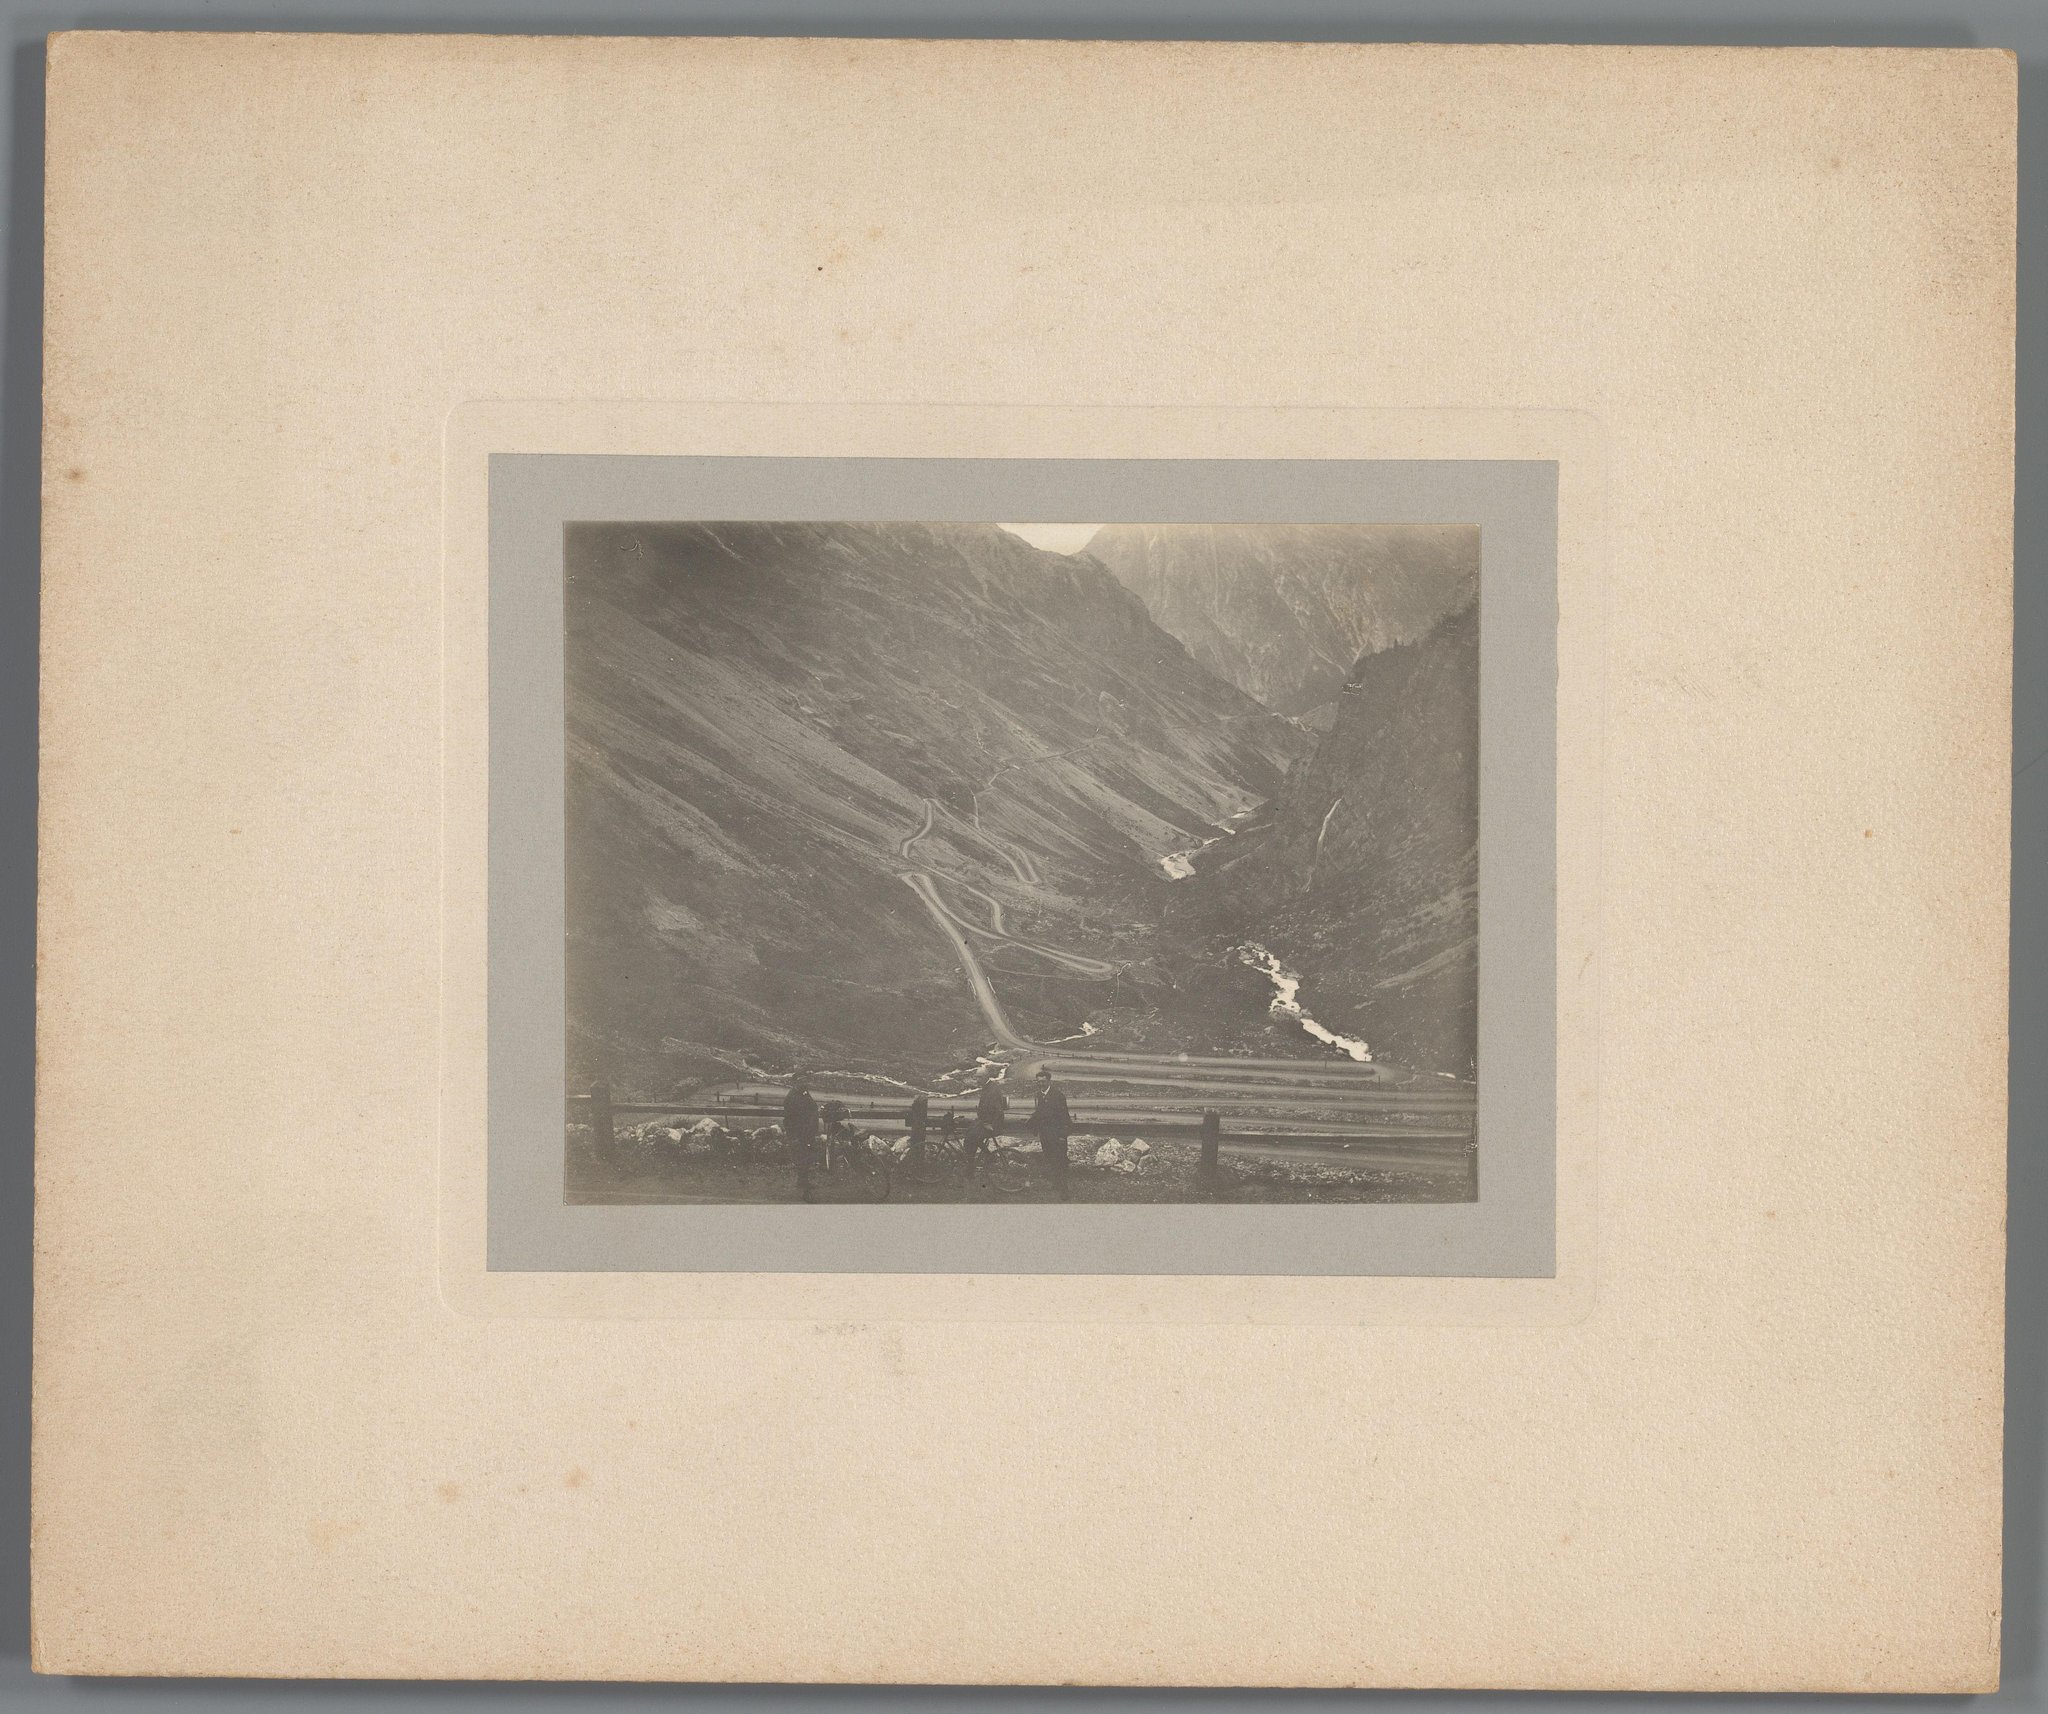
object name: photograph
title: Op weg Stilfser Joch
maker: françois buys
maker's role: advocaat, amateurfotograaf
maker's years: 1871-1934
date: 1905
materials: paper, cardboard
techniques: gelatin silver print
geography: stelviopas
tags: dale, valley, bicycle, mountains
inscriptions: inscription: ‘Op weg Stilfser Joch’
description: Deze foto maakt deel uit van een groep van 38 foto's.